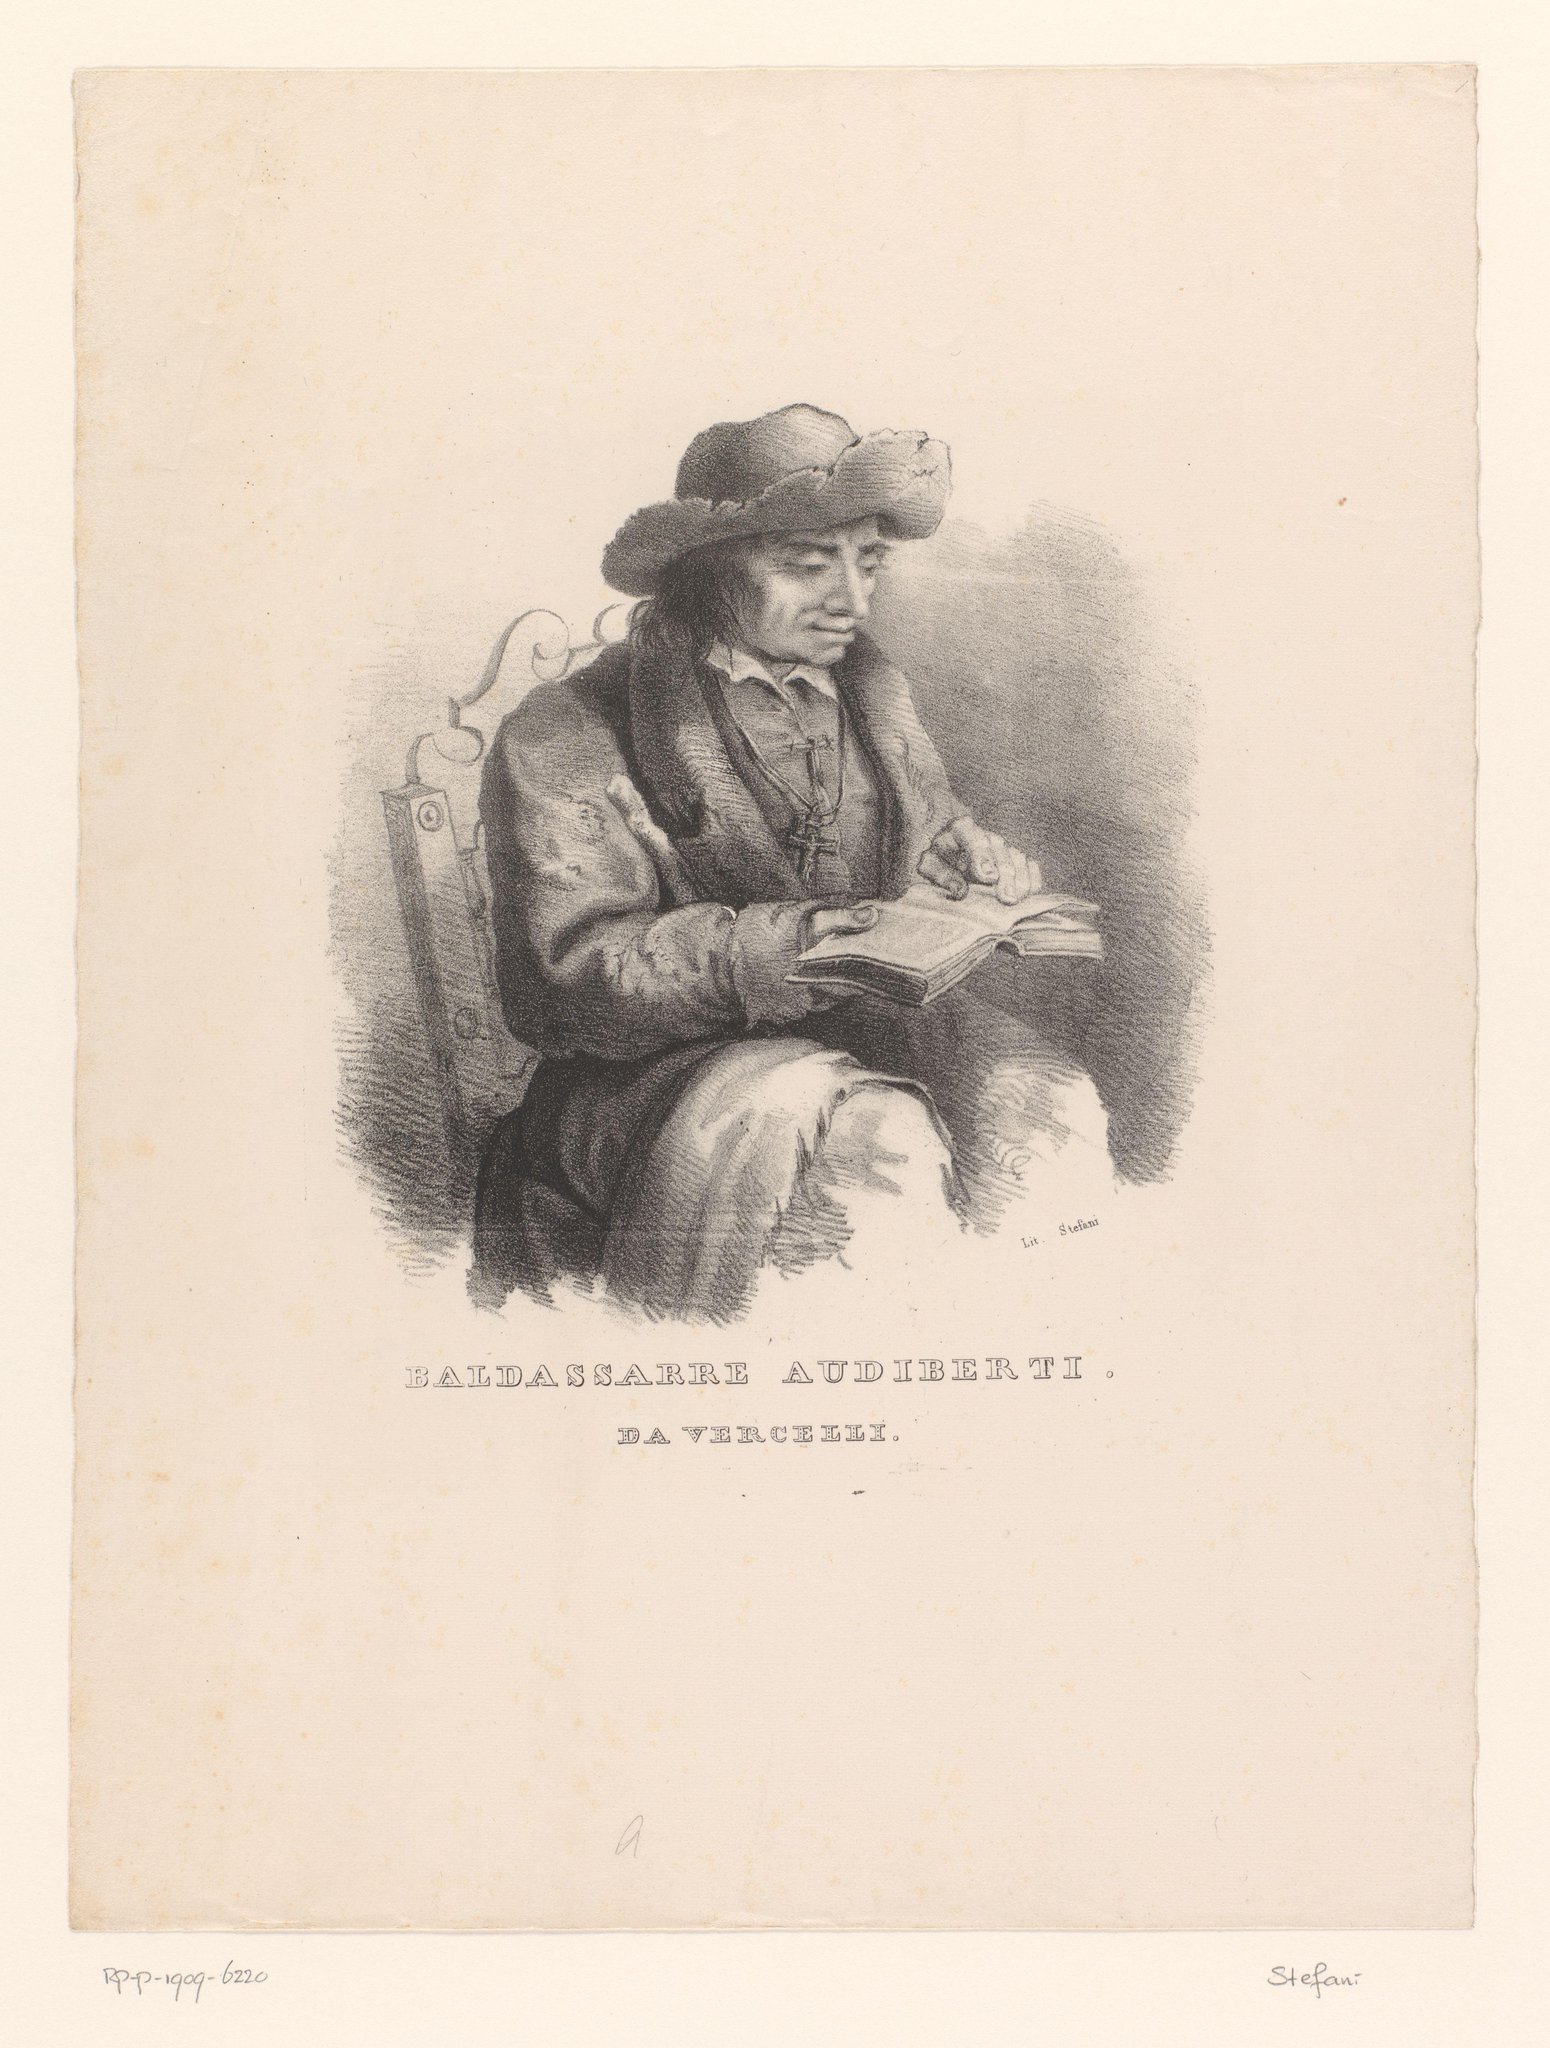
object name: print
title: Portret van geestelijke Baldassarre Audiberti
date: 1800-1899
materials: paper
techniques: lithograph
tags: historical persons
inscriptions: collector's mark: Lugt 2228